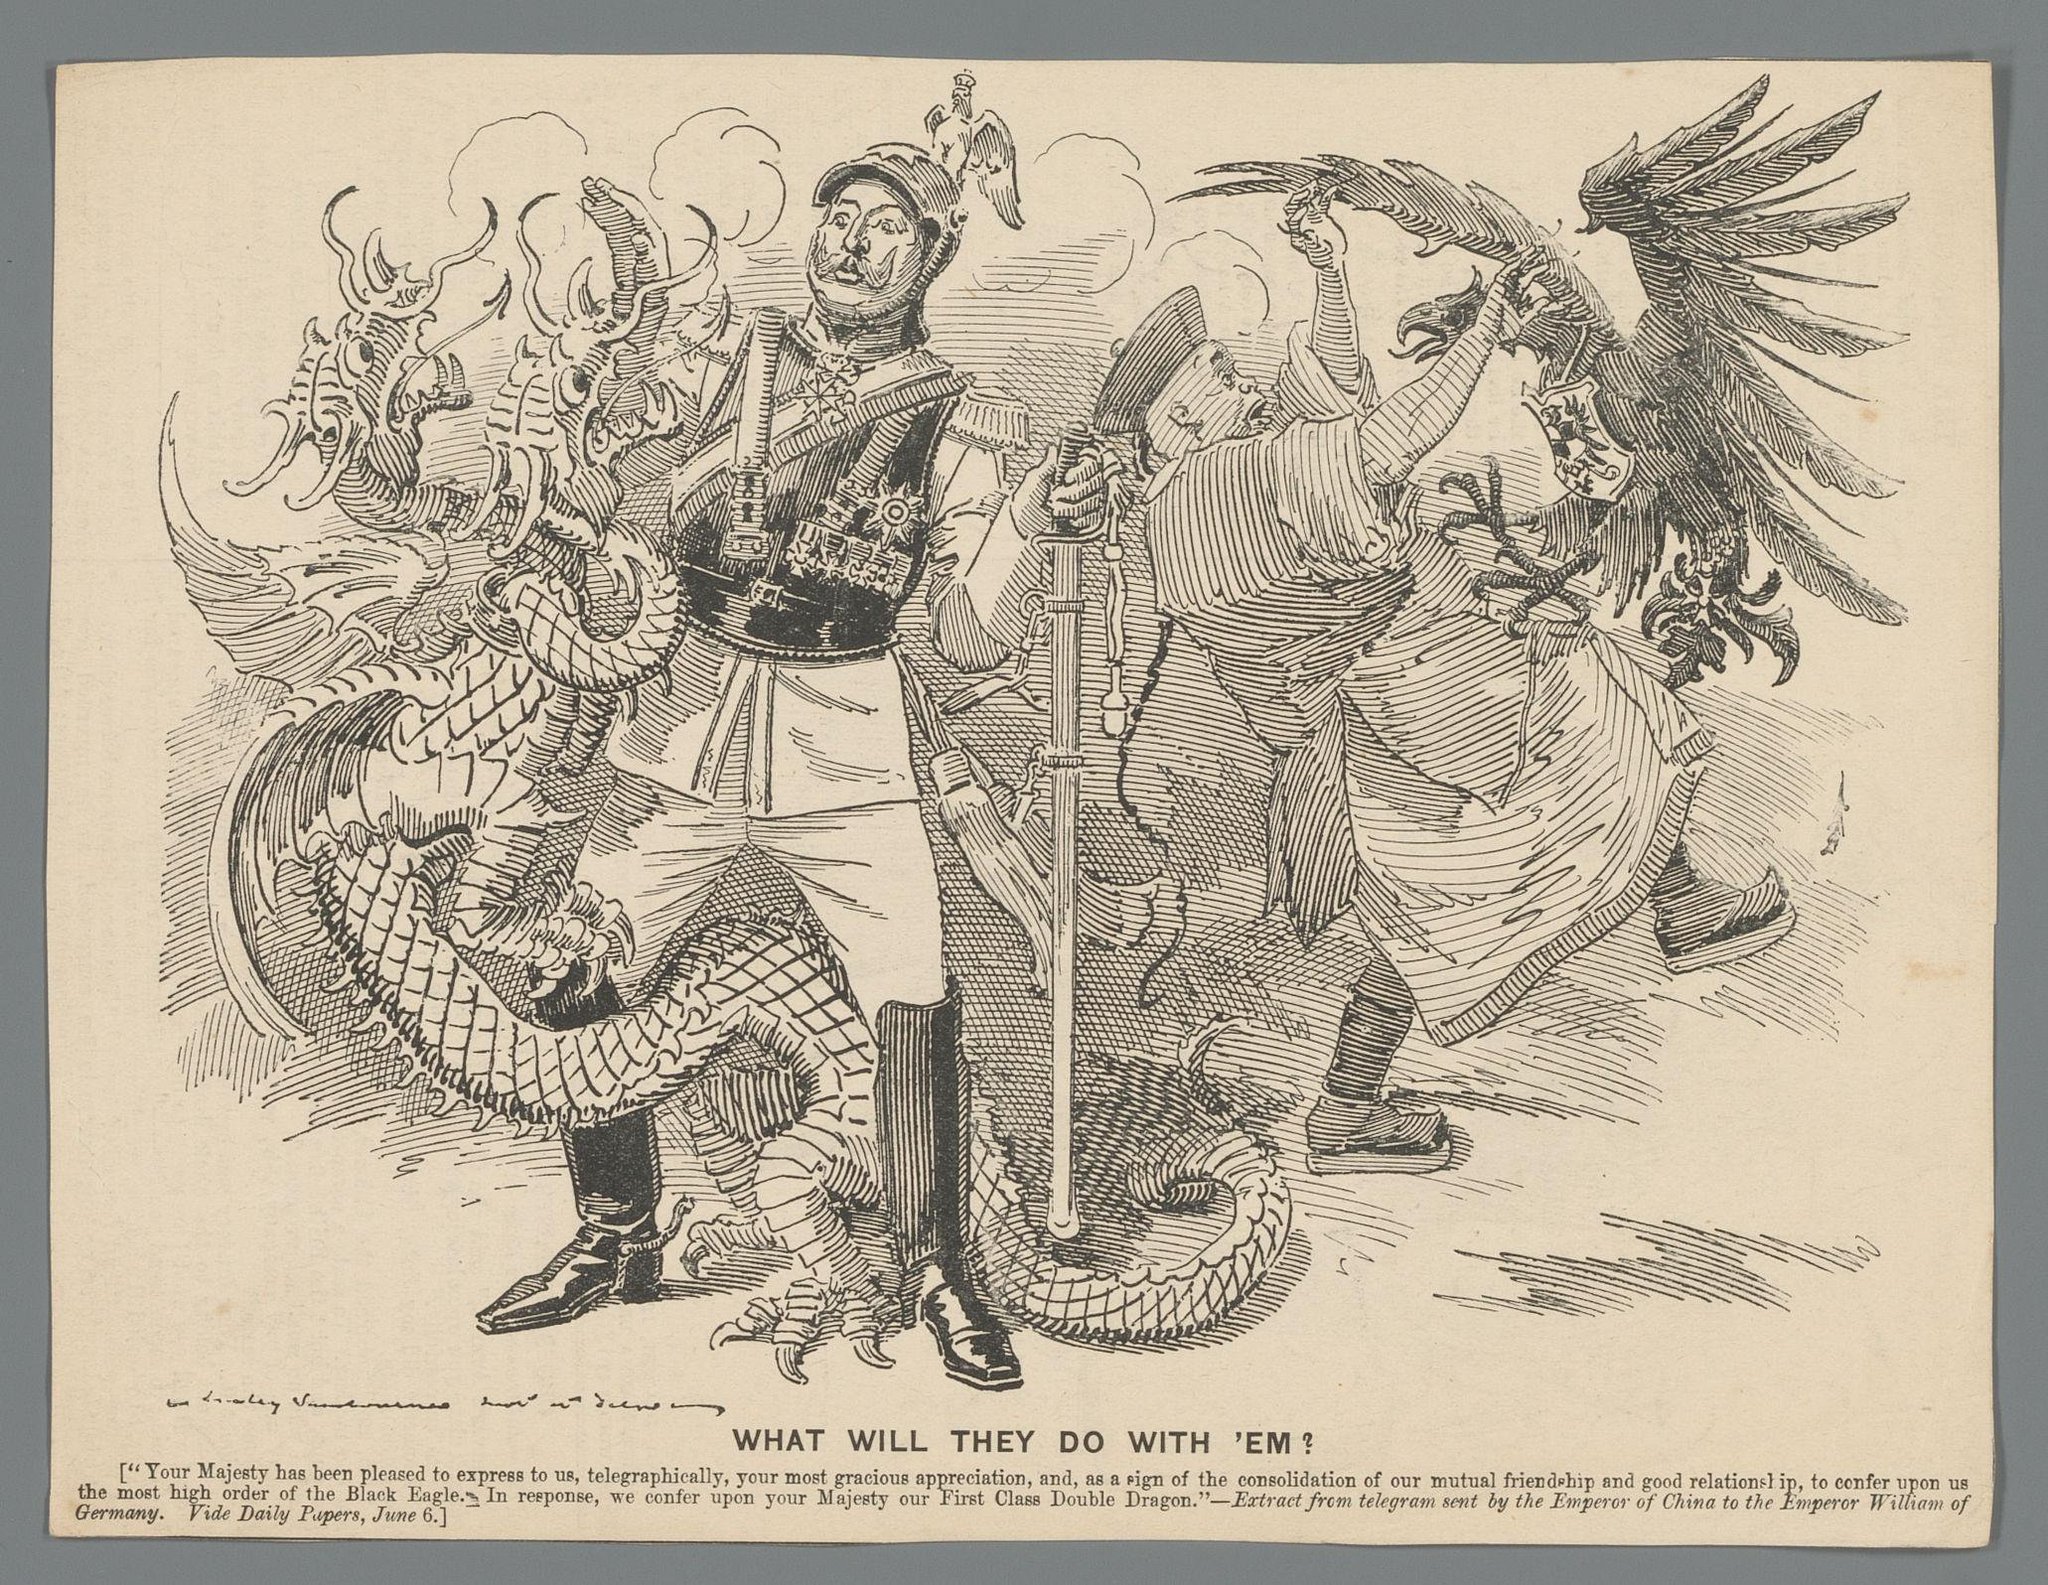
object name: print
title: Spotprent op Duitsland en China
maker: edward linley sambourne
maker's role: draughtsman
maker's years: 1844-1910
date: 1898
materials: paper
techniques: line block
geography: england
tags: personifications of countries, nations, states, districts, etc., political caricatures and satires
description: Spotprent op Duitsland en China die elkaar onderscheiden met de ordetekenen van de zwarte adelaar en de tweekoppige draak. Spotprent in het Engelse satirische tijdschrift Punch, 1898.